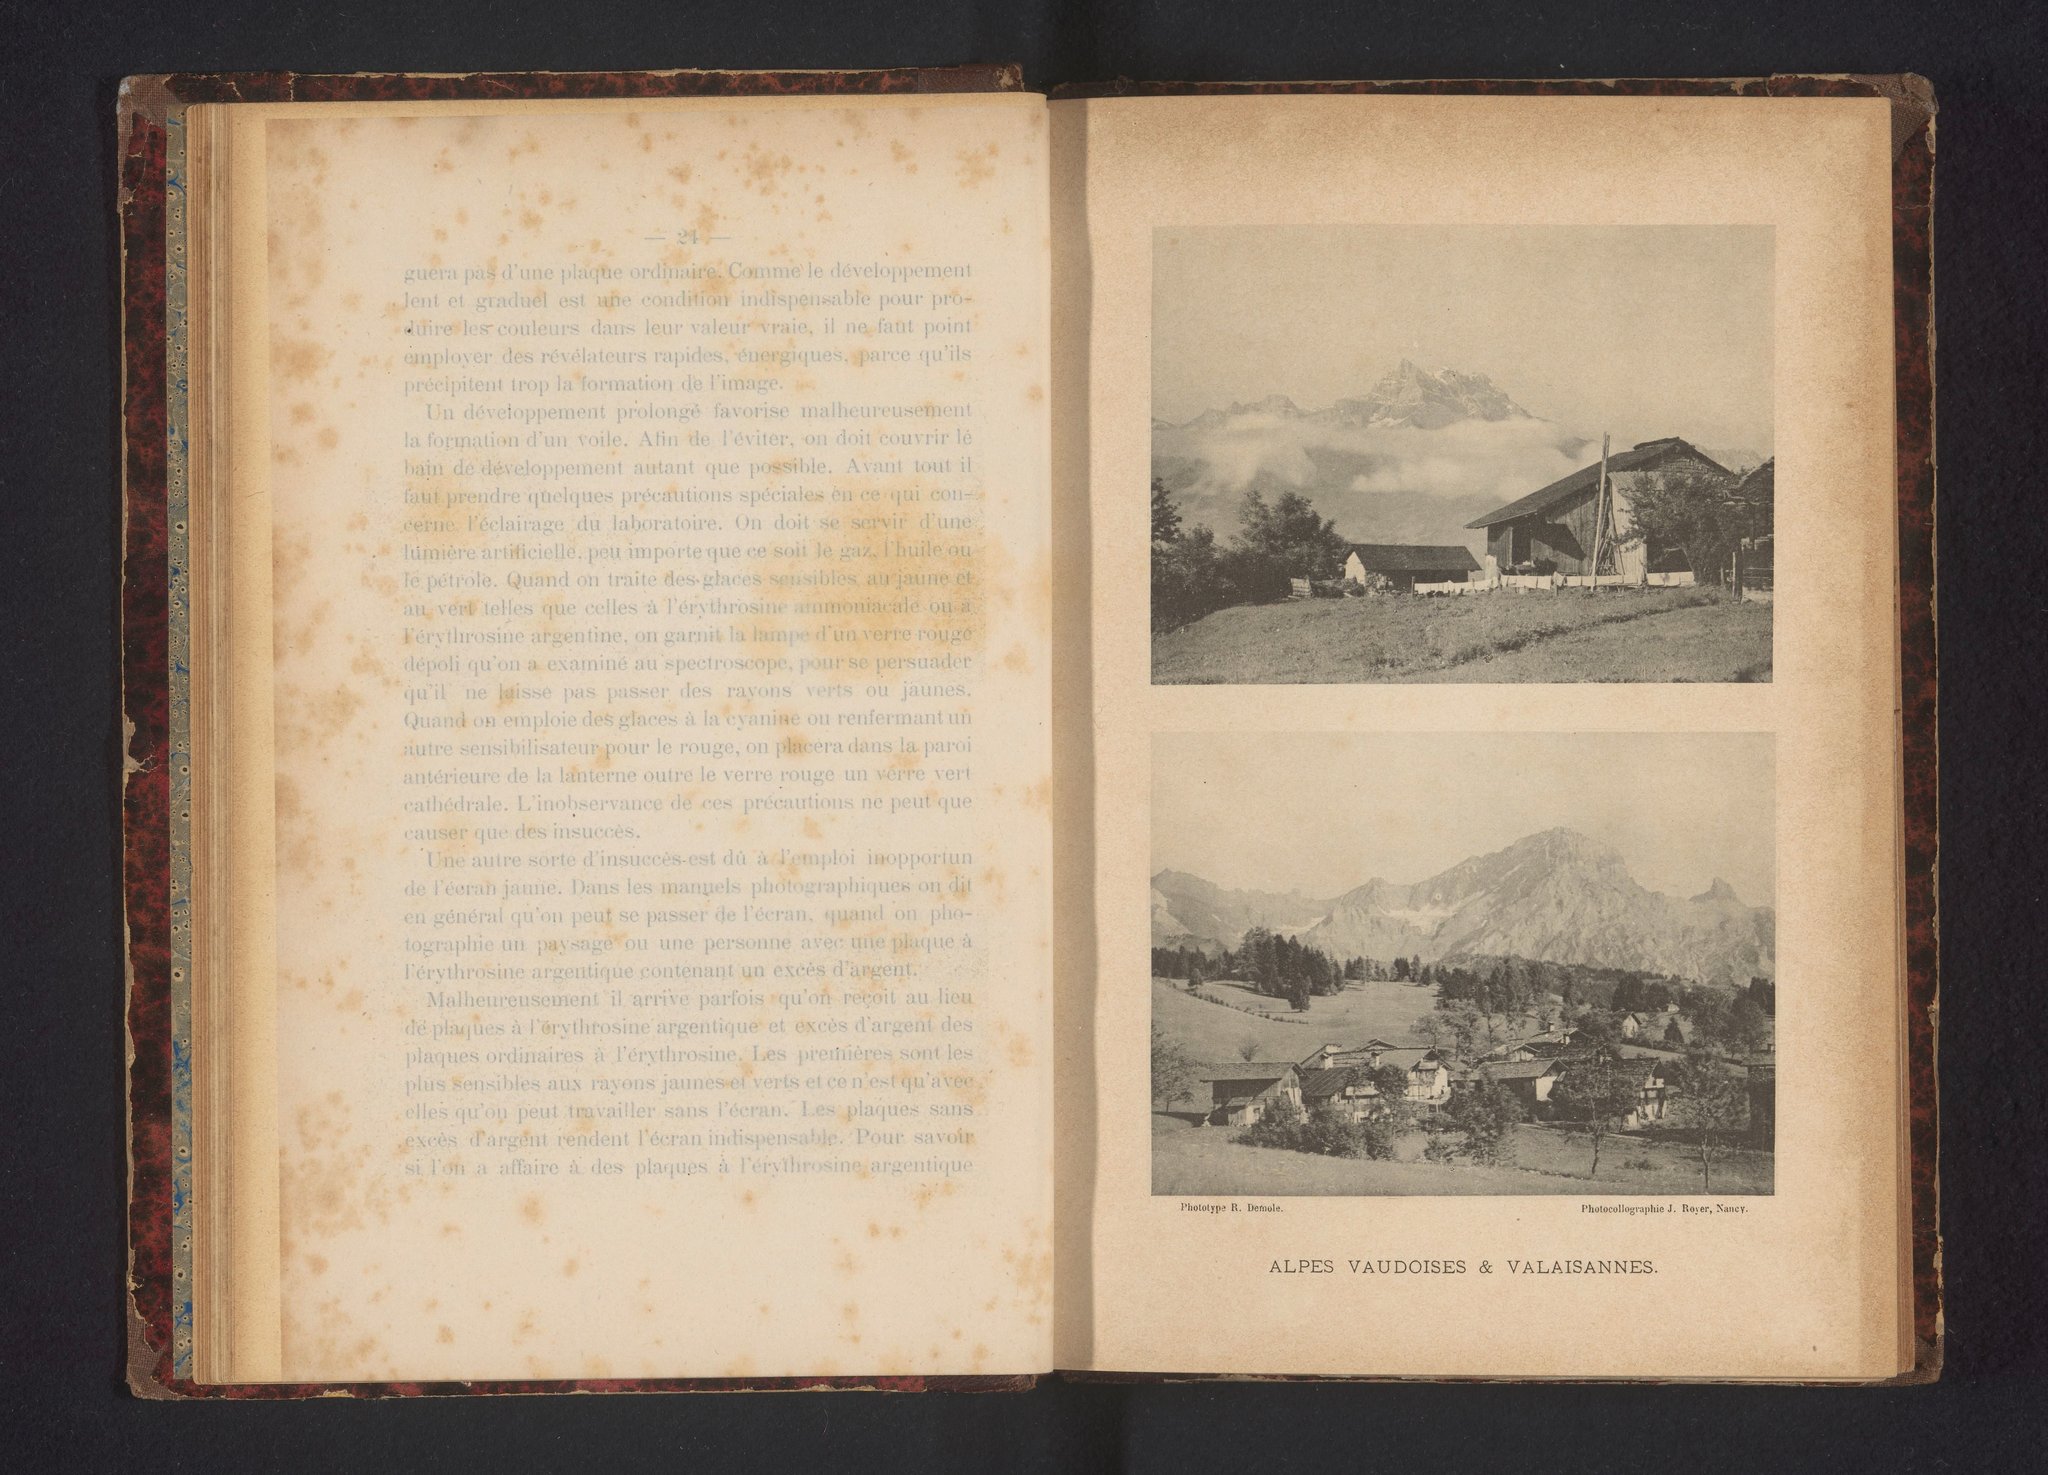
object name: page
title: Alpes Vaudoises & Valaisannes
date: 1890-1895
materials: paper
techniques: photograph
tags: city-view, and landscape with man-made constructions, mountains